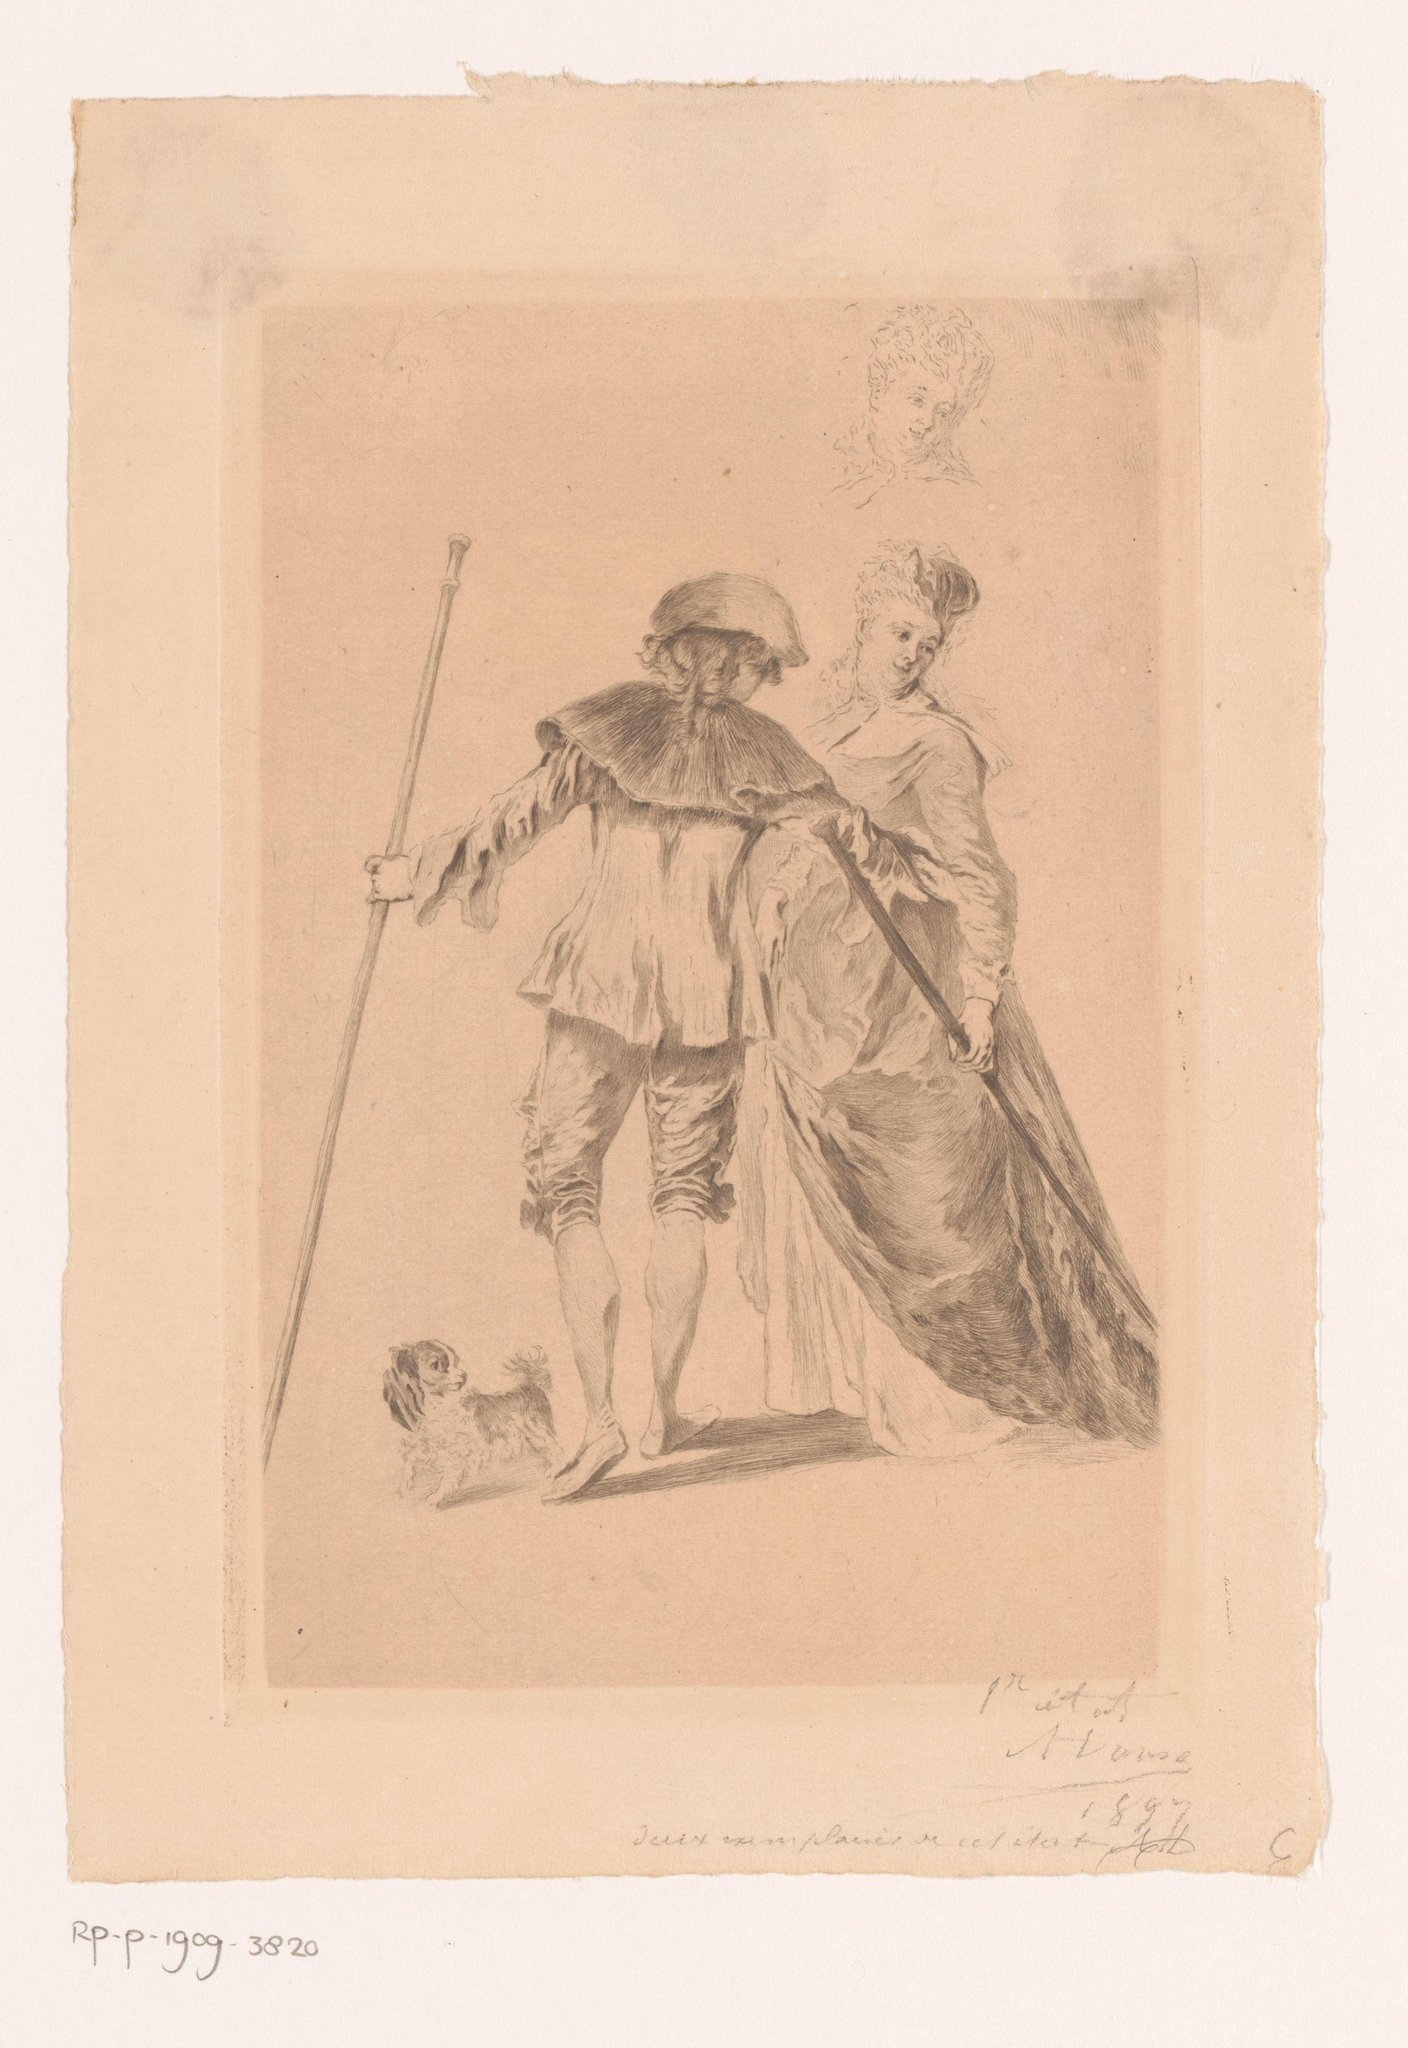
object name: print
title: Romantisch koppel edellieden met een hond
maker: auguste danse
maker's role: print maker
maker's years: 1829-1929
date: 1897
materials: paper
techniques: drypoint, etching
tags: (lovers) embracing each other, 'symplegma'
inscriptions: annotation: ‘1er état; deux exemplaires de cet état’, collector's mark: Lugt 2228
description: Dit detail is het centrale paar in het schilderij L'Embarquement pour Cythère.